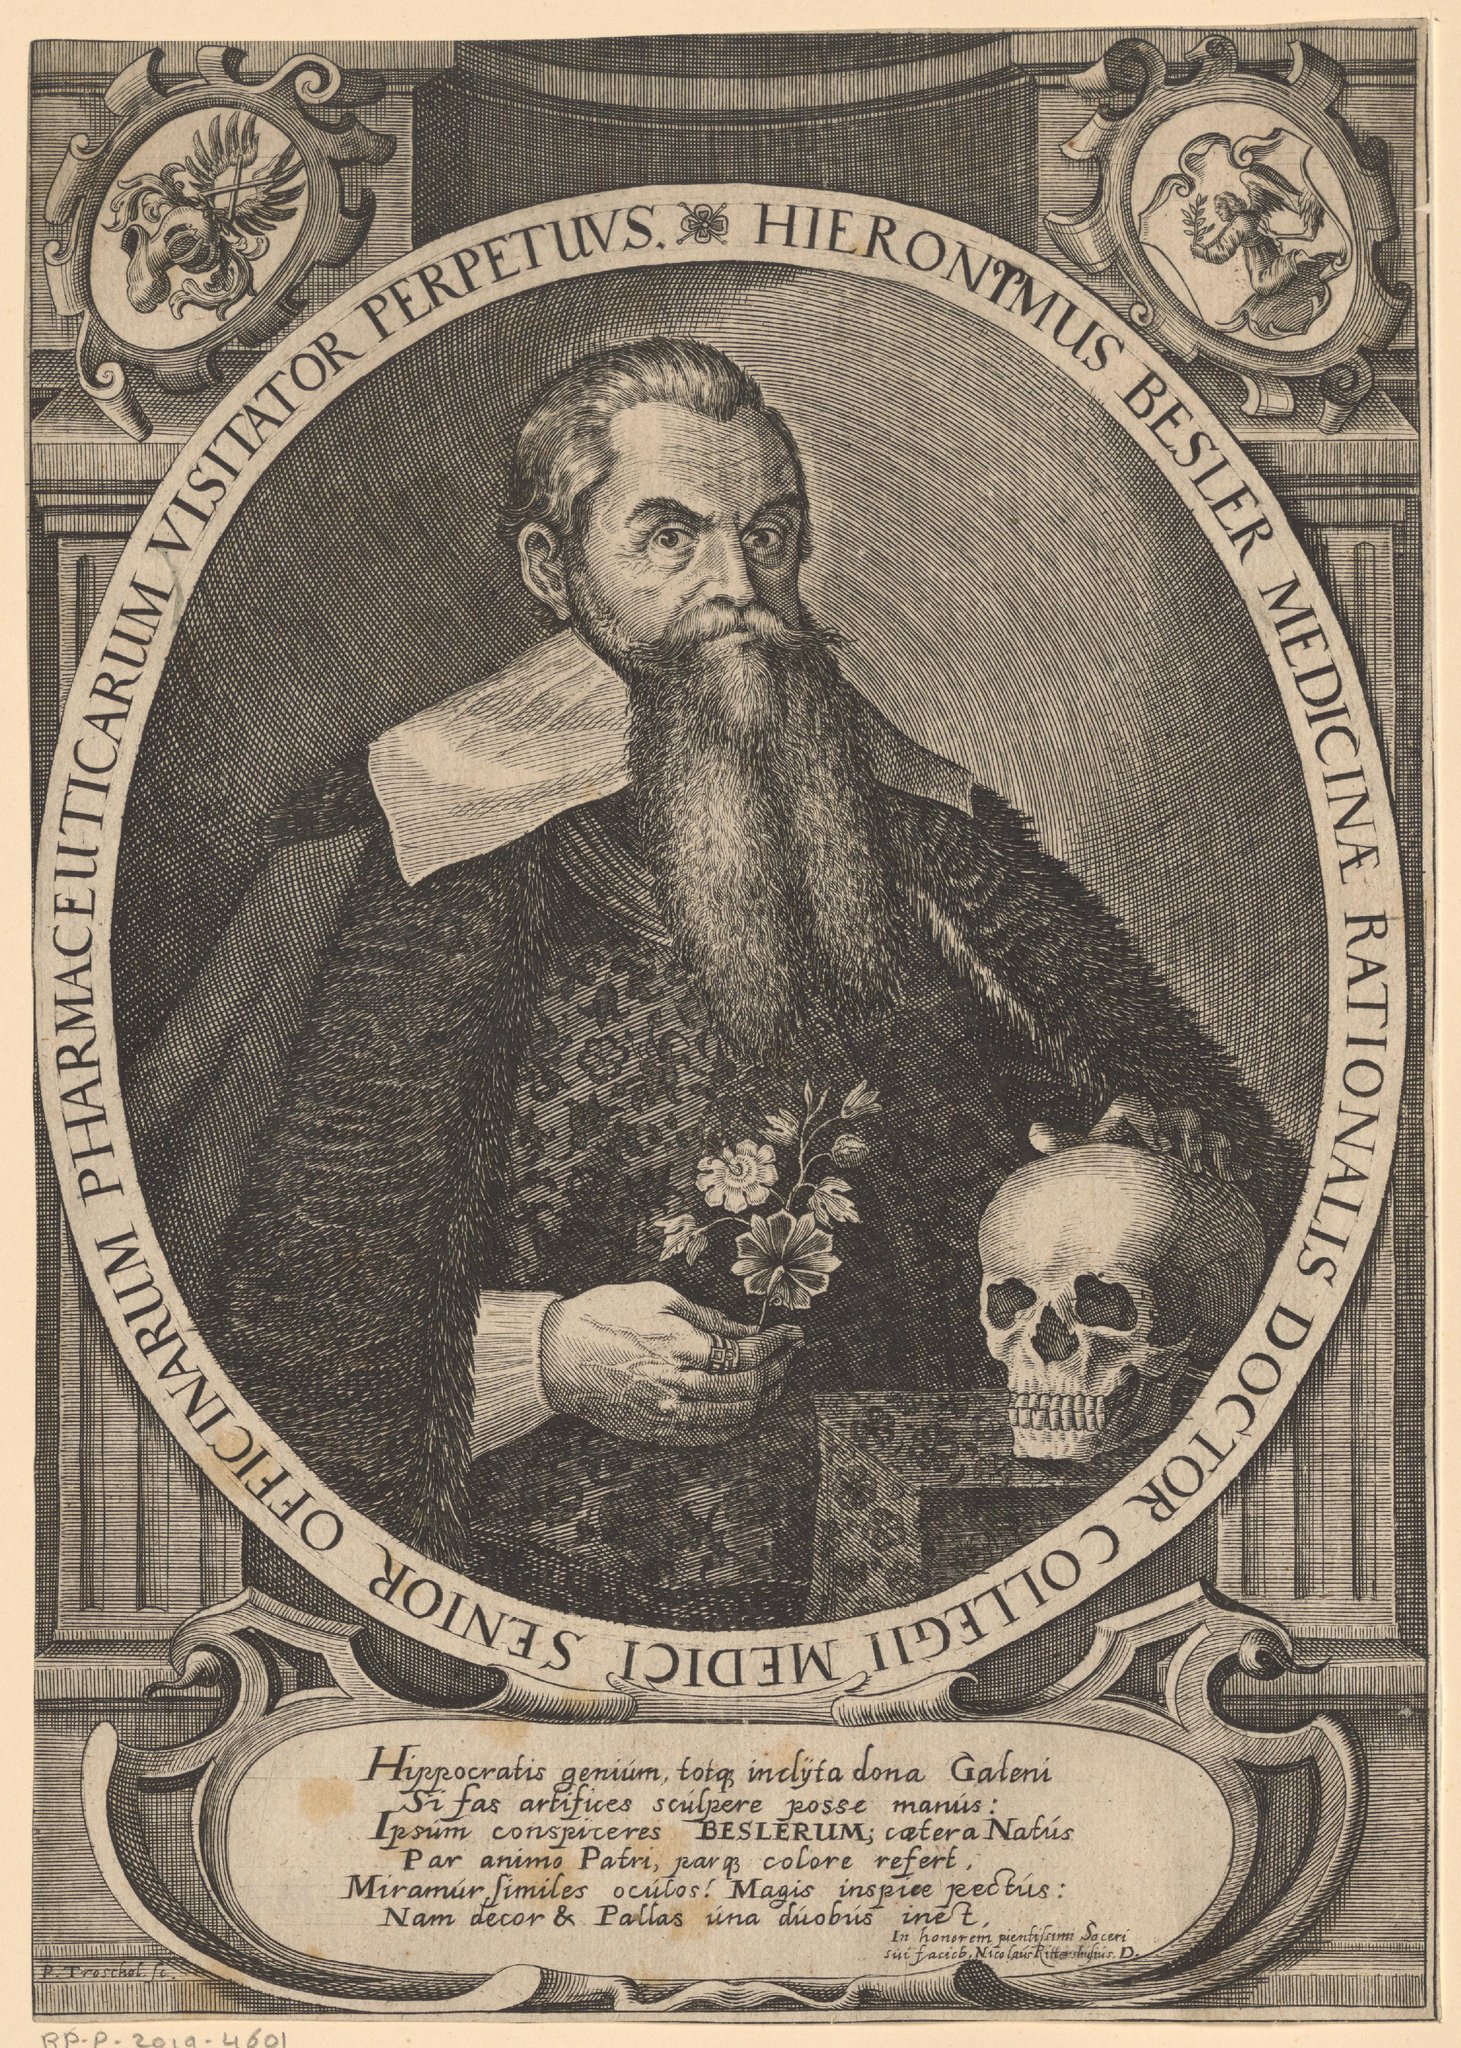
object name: print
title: Portret van Hieronymus Besler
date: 1630-1670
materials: paper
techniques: engraving, etching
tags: flowers, historical persons, armorial bearing, heraldry, death's head, skull (symbol of death)